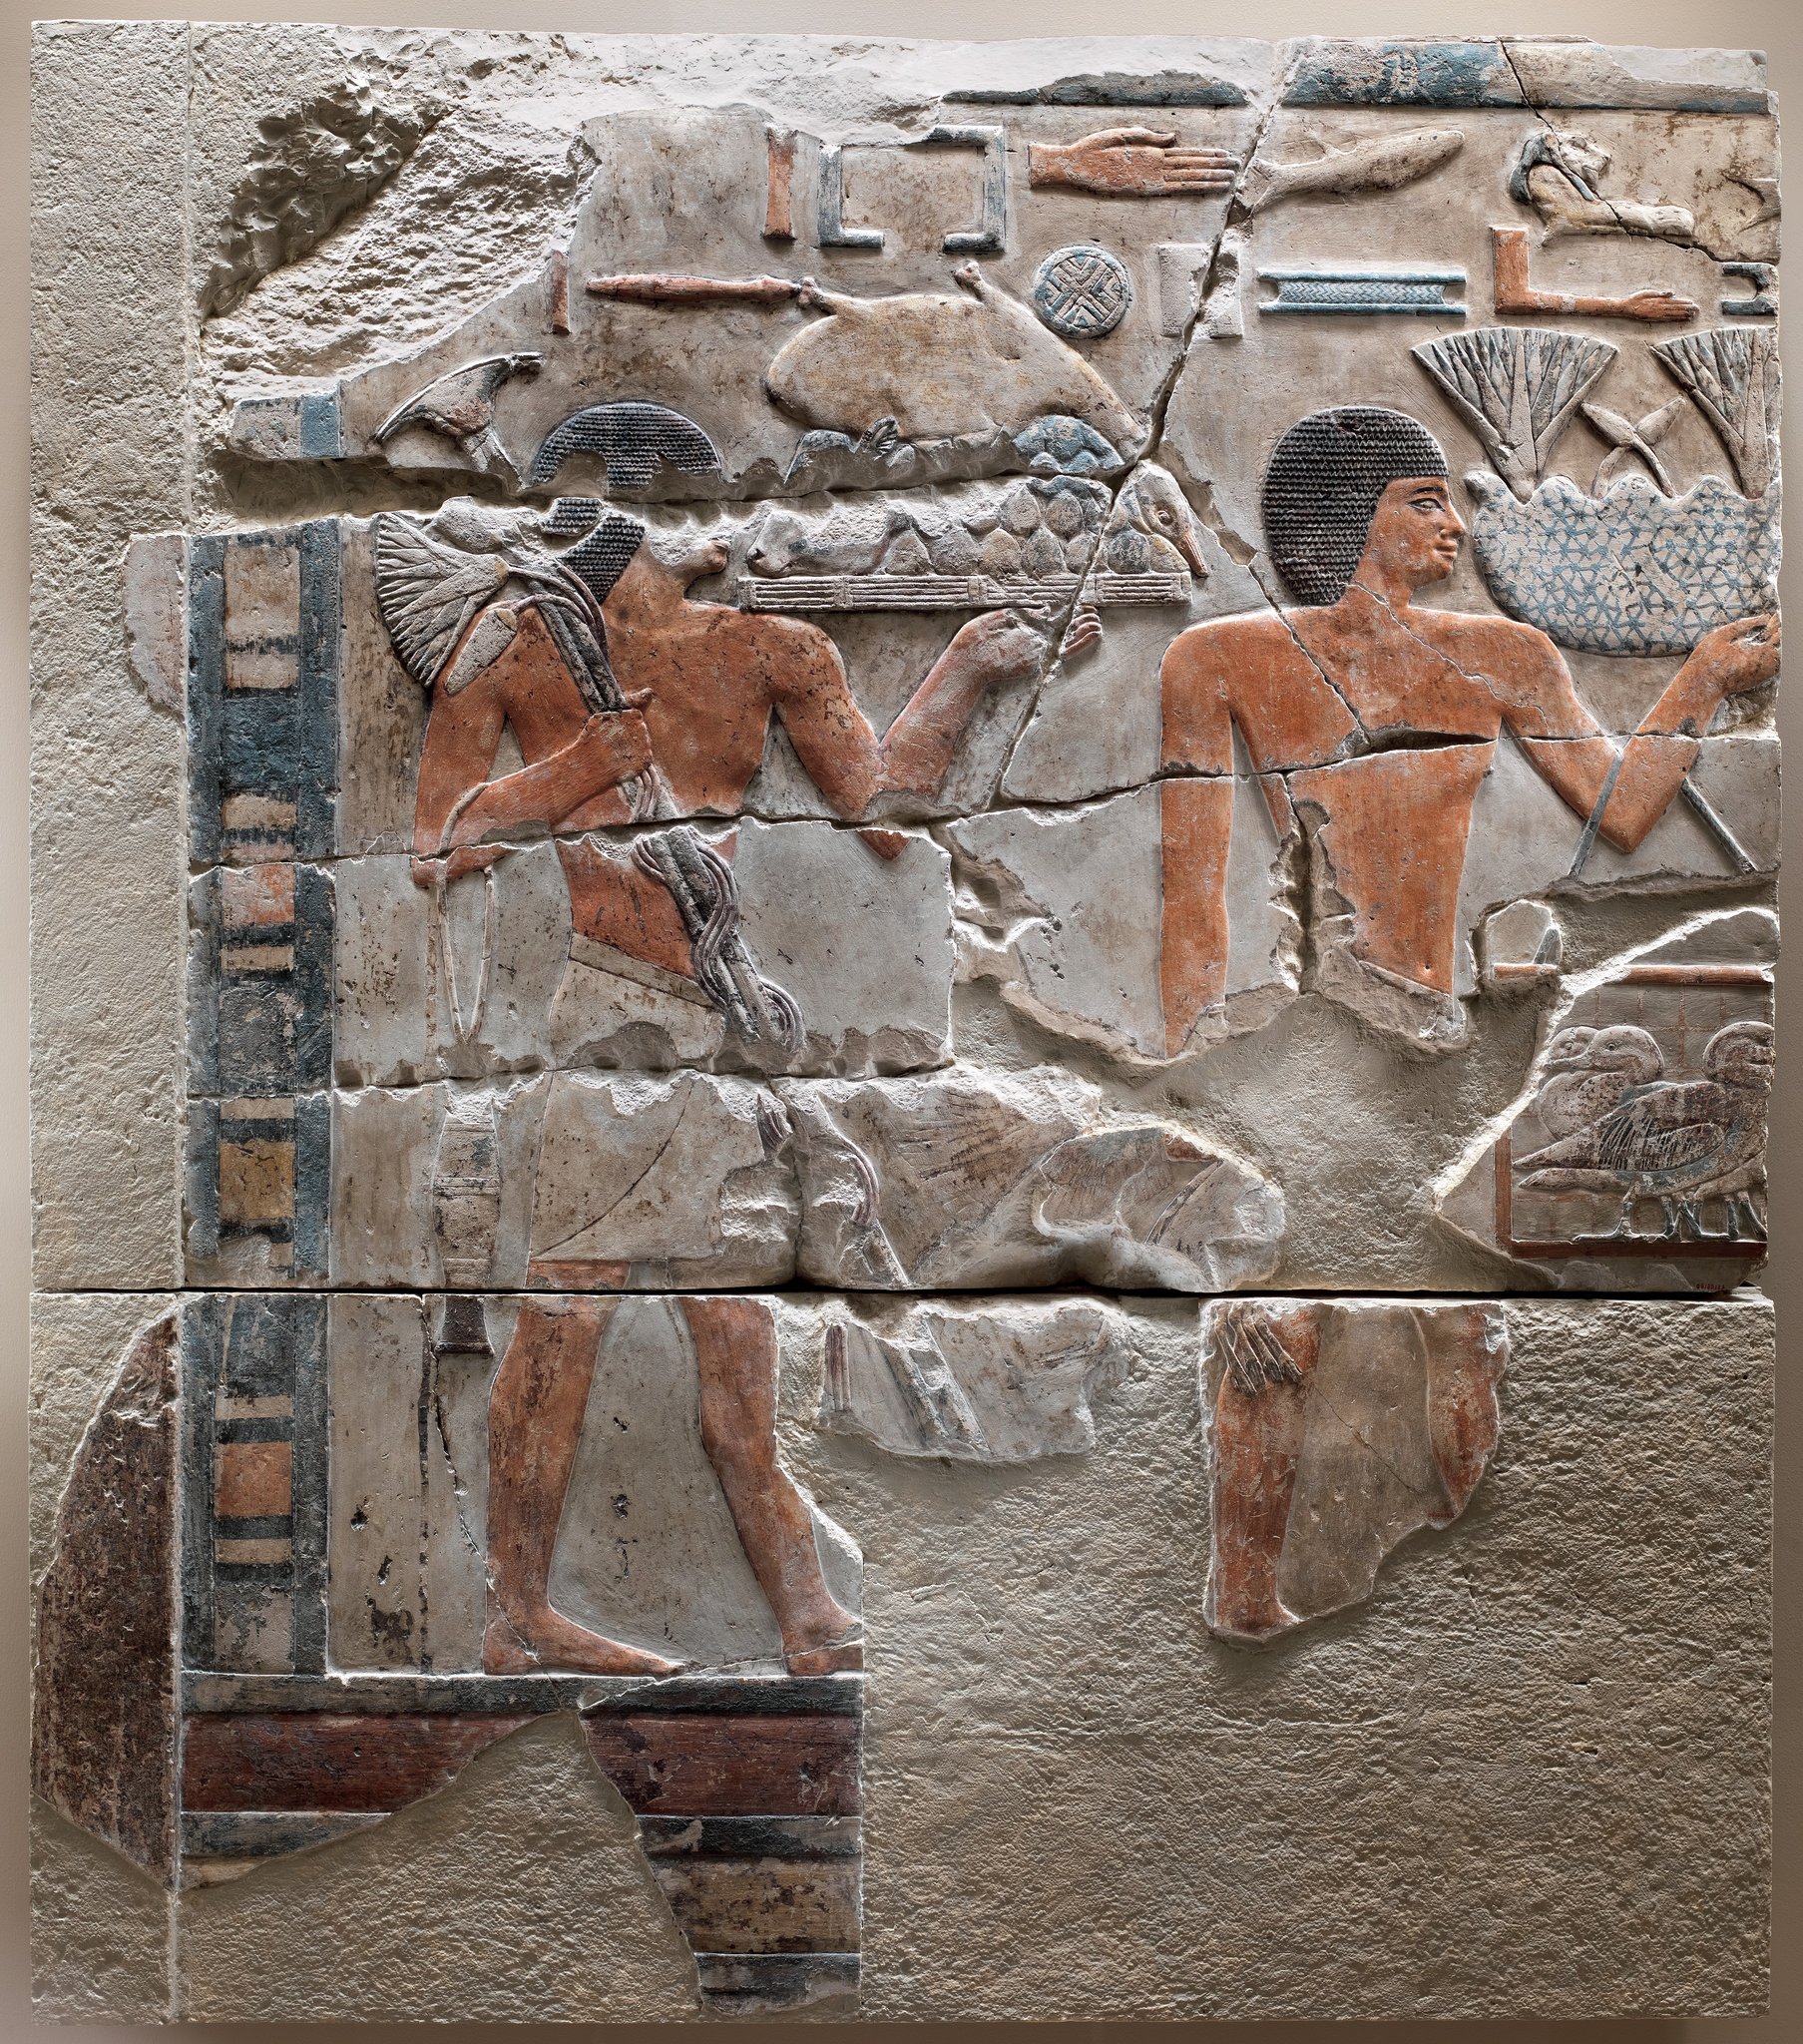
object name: relief, senwosret i, offering bearer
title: Relief showing procession of offering bearers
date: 1961-1917 BCE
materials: limestone, paint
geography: egypt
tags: birds,men,lotuses